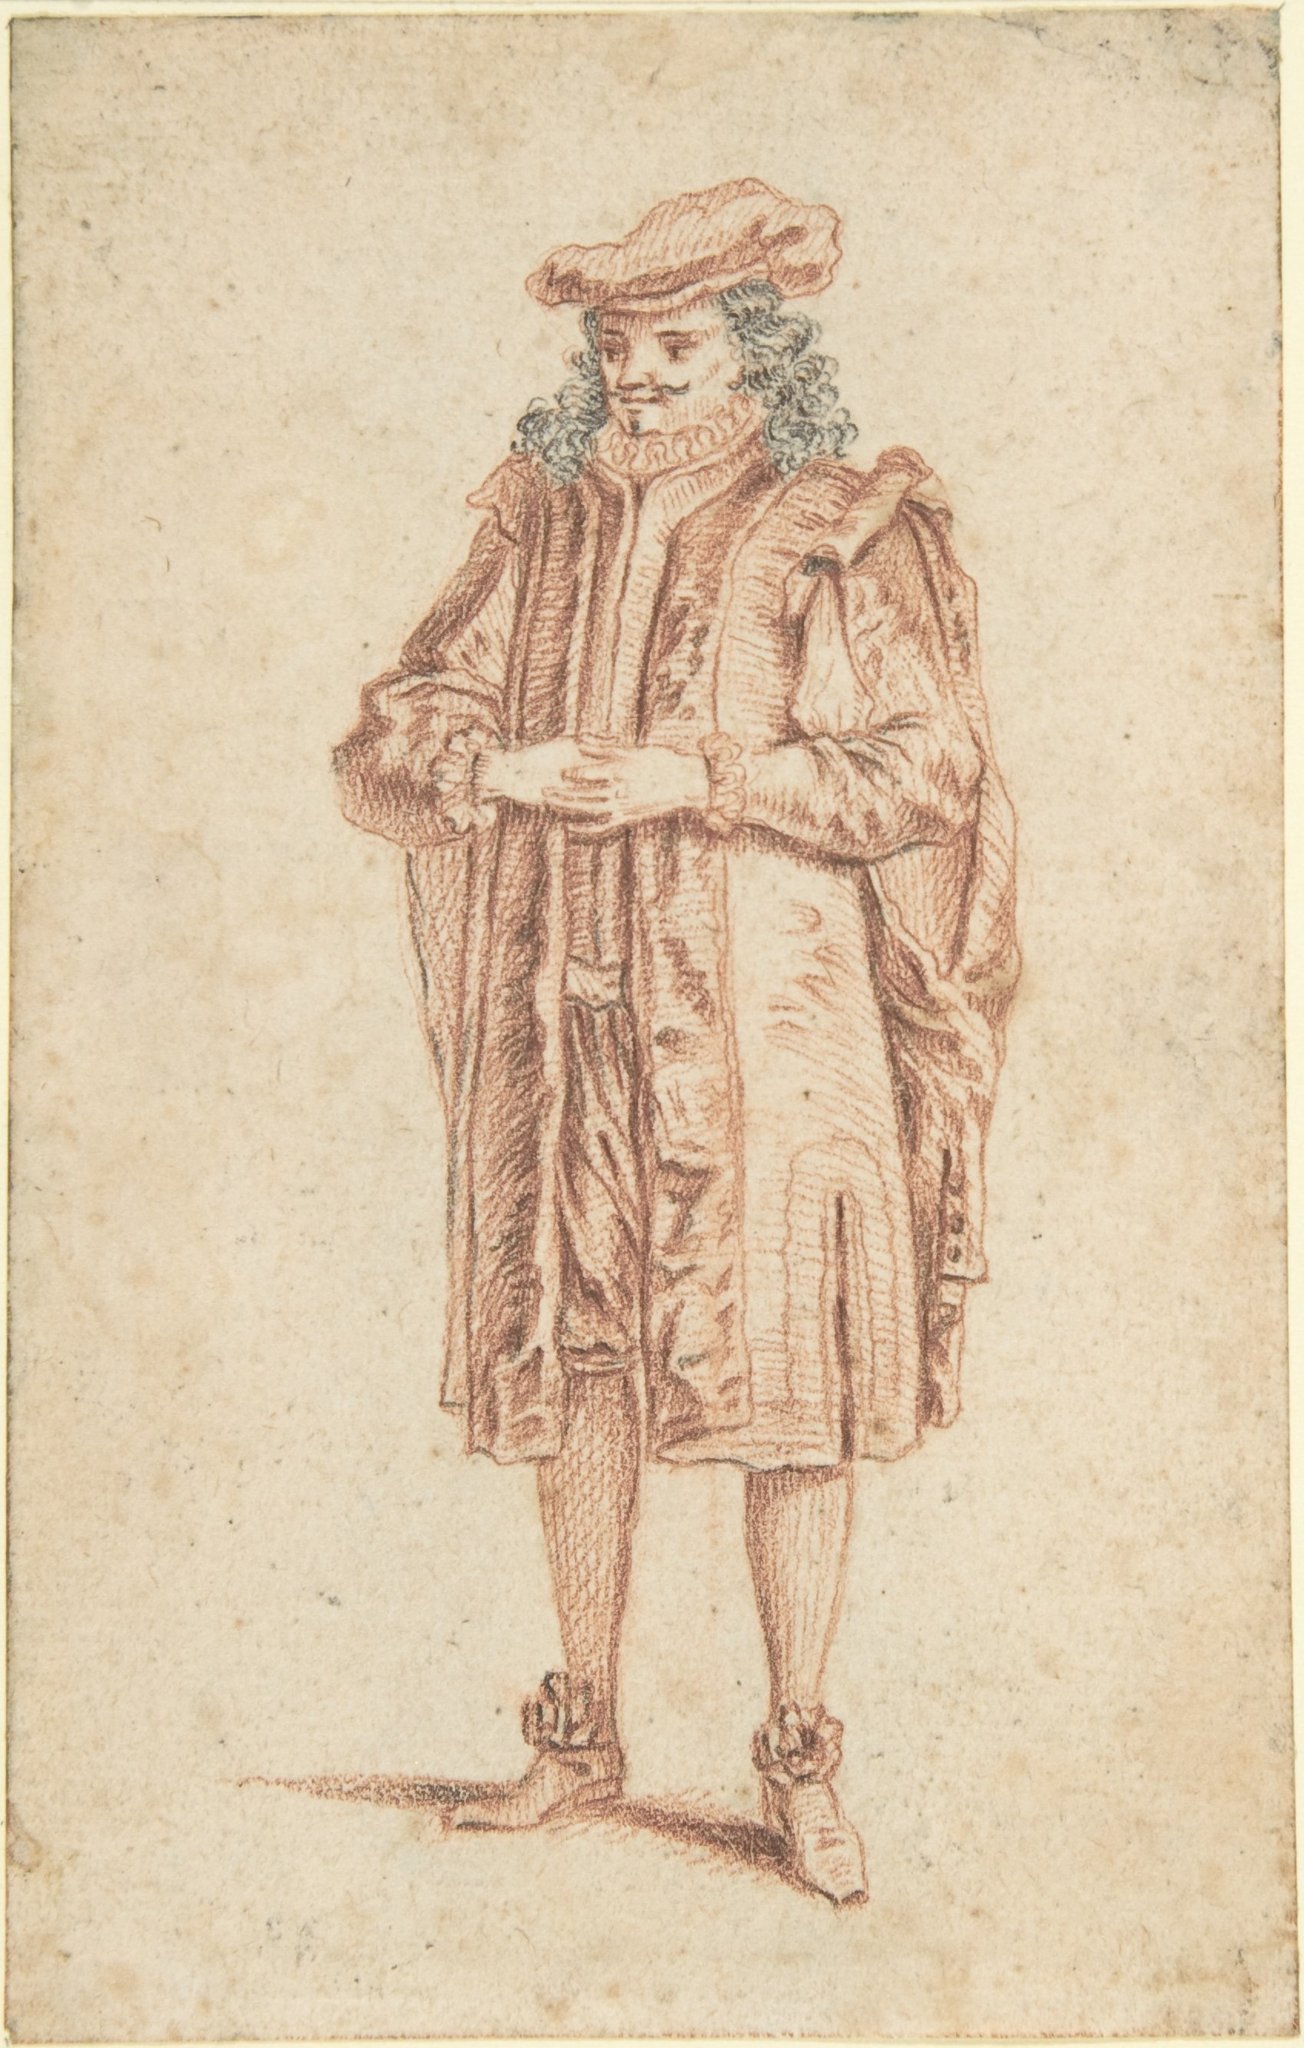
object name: drawing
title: Crepin's Master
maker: claude gillot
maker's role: artist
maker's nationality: french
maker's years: 1673-1722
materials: chalk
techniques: transfer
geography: france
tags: men